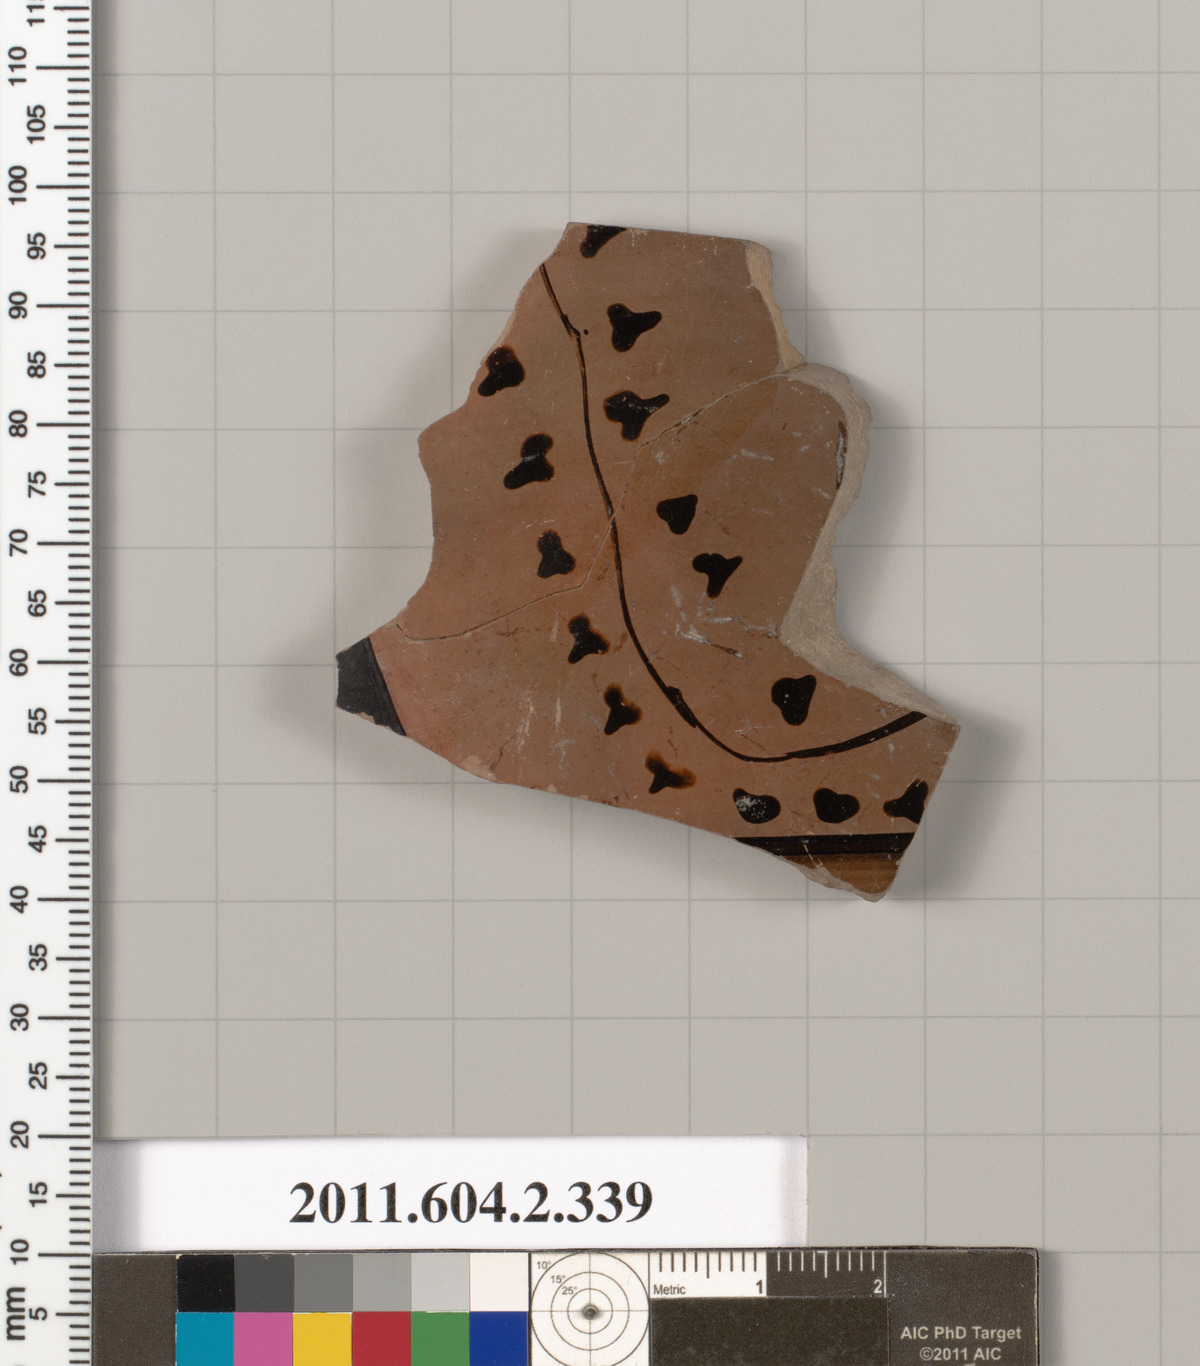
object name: column krater fragment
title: Terracotta fragment of a column-krater (bowl for mixing wine and water)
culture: greek, attic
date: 475-451 BCE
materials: terracotta